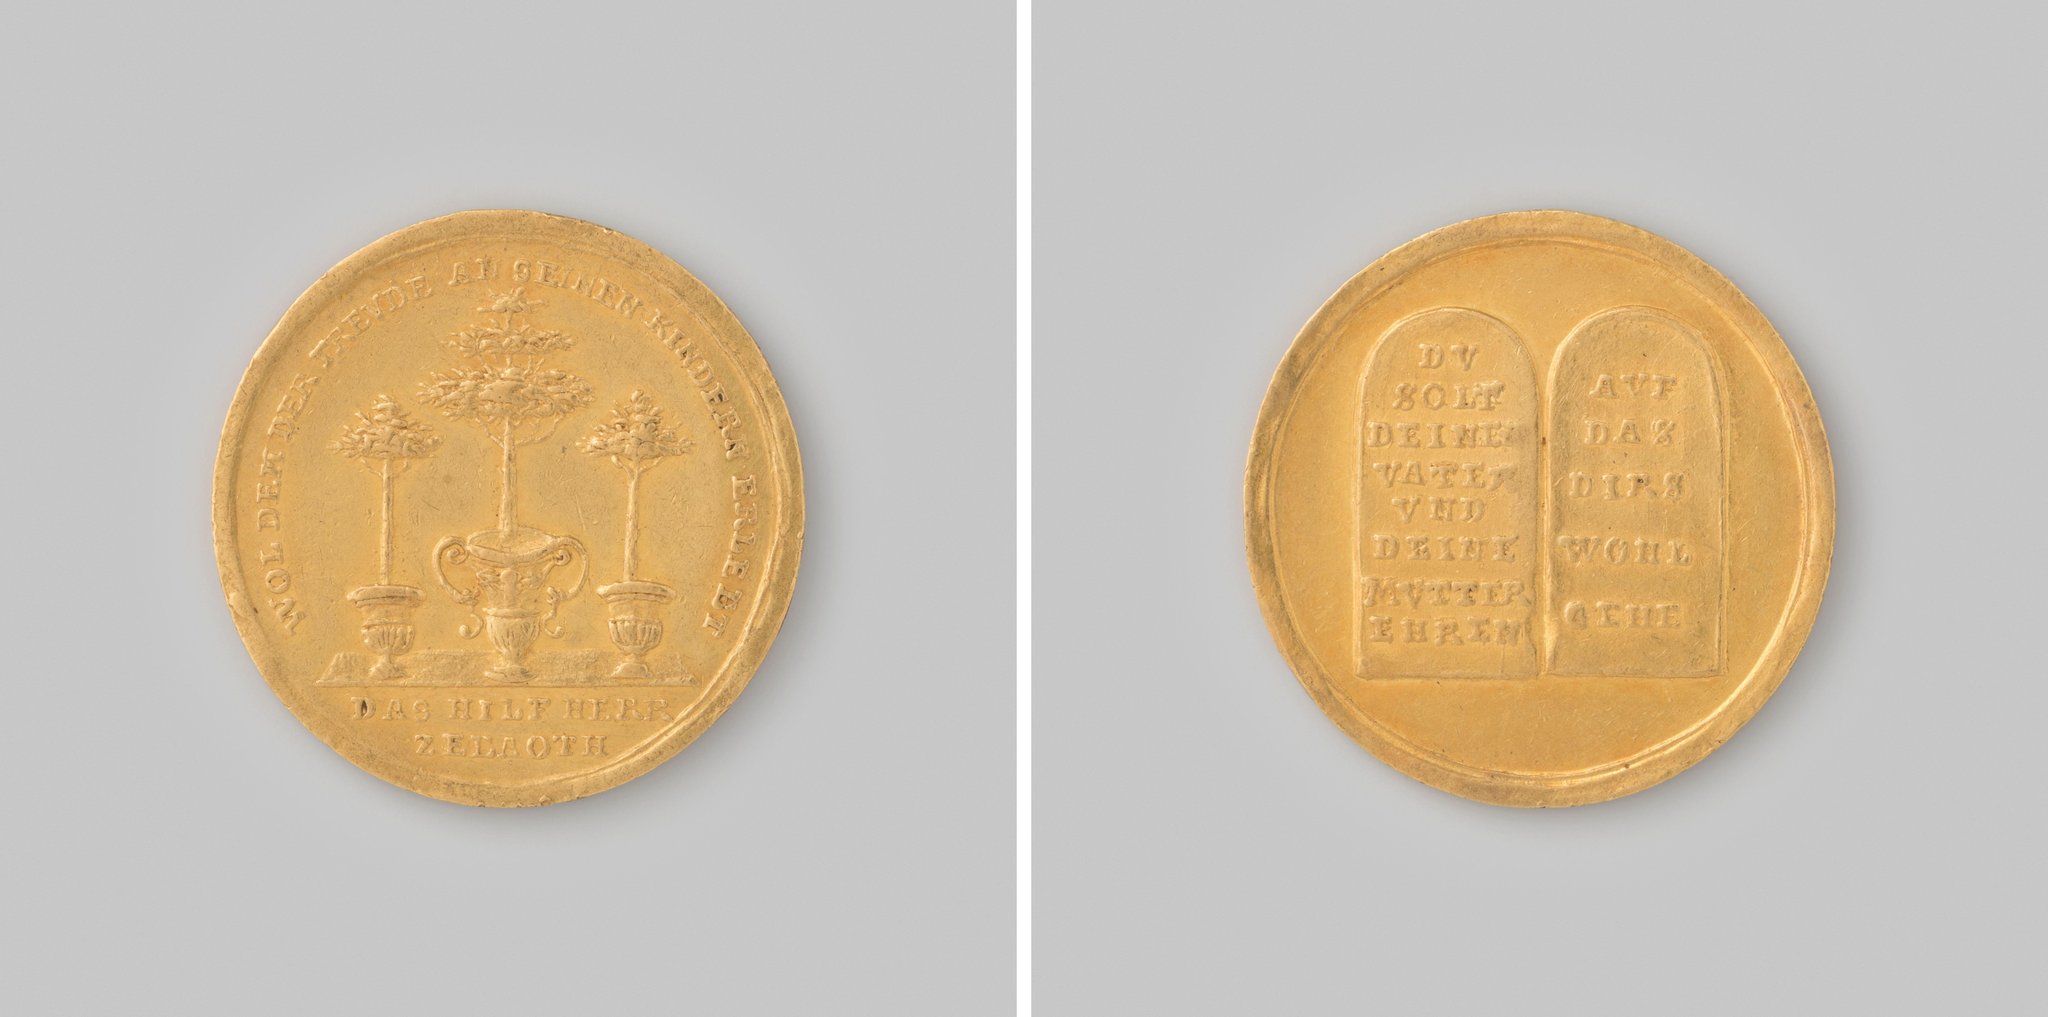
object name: coin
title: Dukaat uit het Duitse Keizerrijk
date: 1600-1800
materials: gold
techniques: striking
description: Gouden gelegenheidsmunt. Voorzijde: op een tafelblad een grotwe vaas, omringd door twee kleinere. In iedere vaas een boom, de middelste met drie kruinen. Keerzijde: twee tafelen der wet, waarop spreuk in acht regels. Gladde rand.